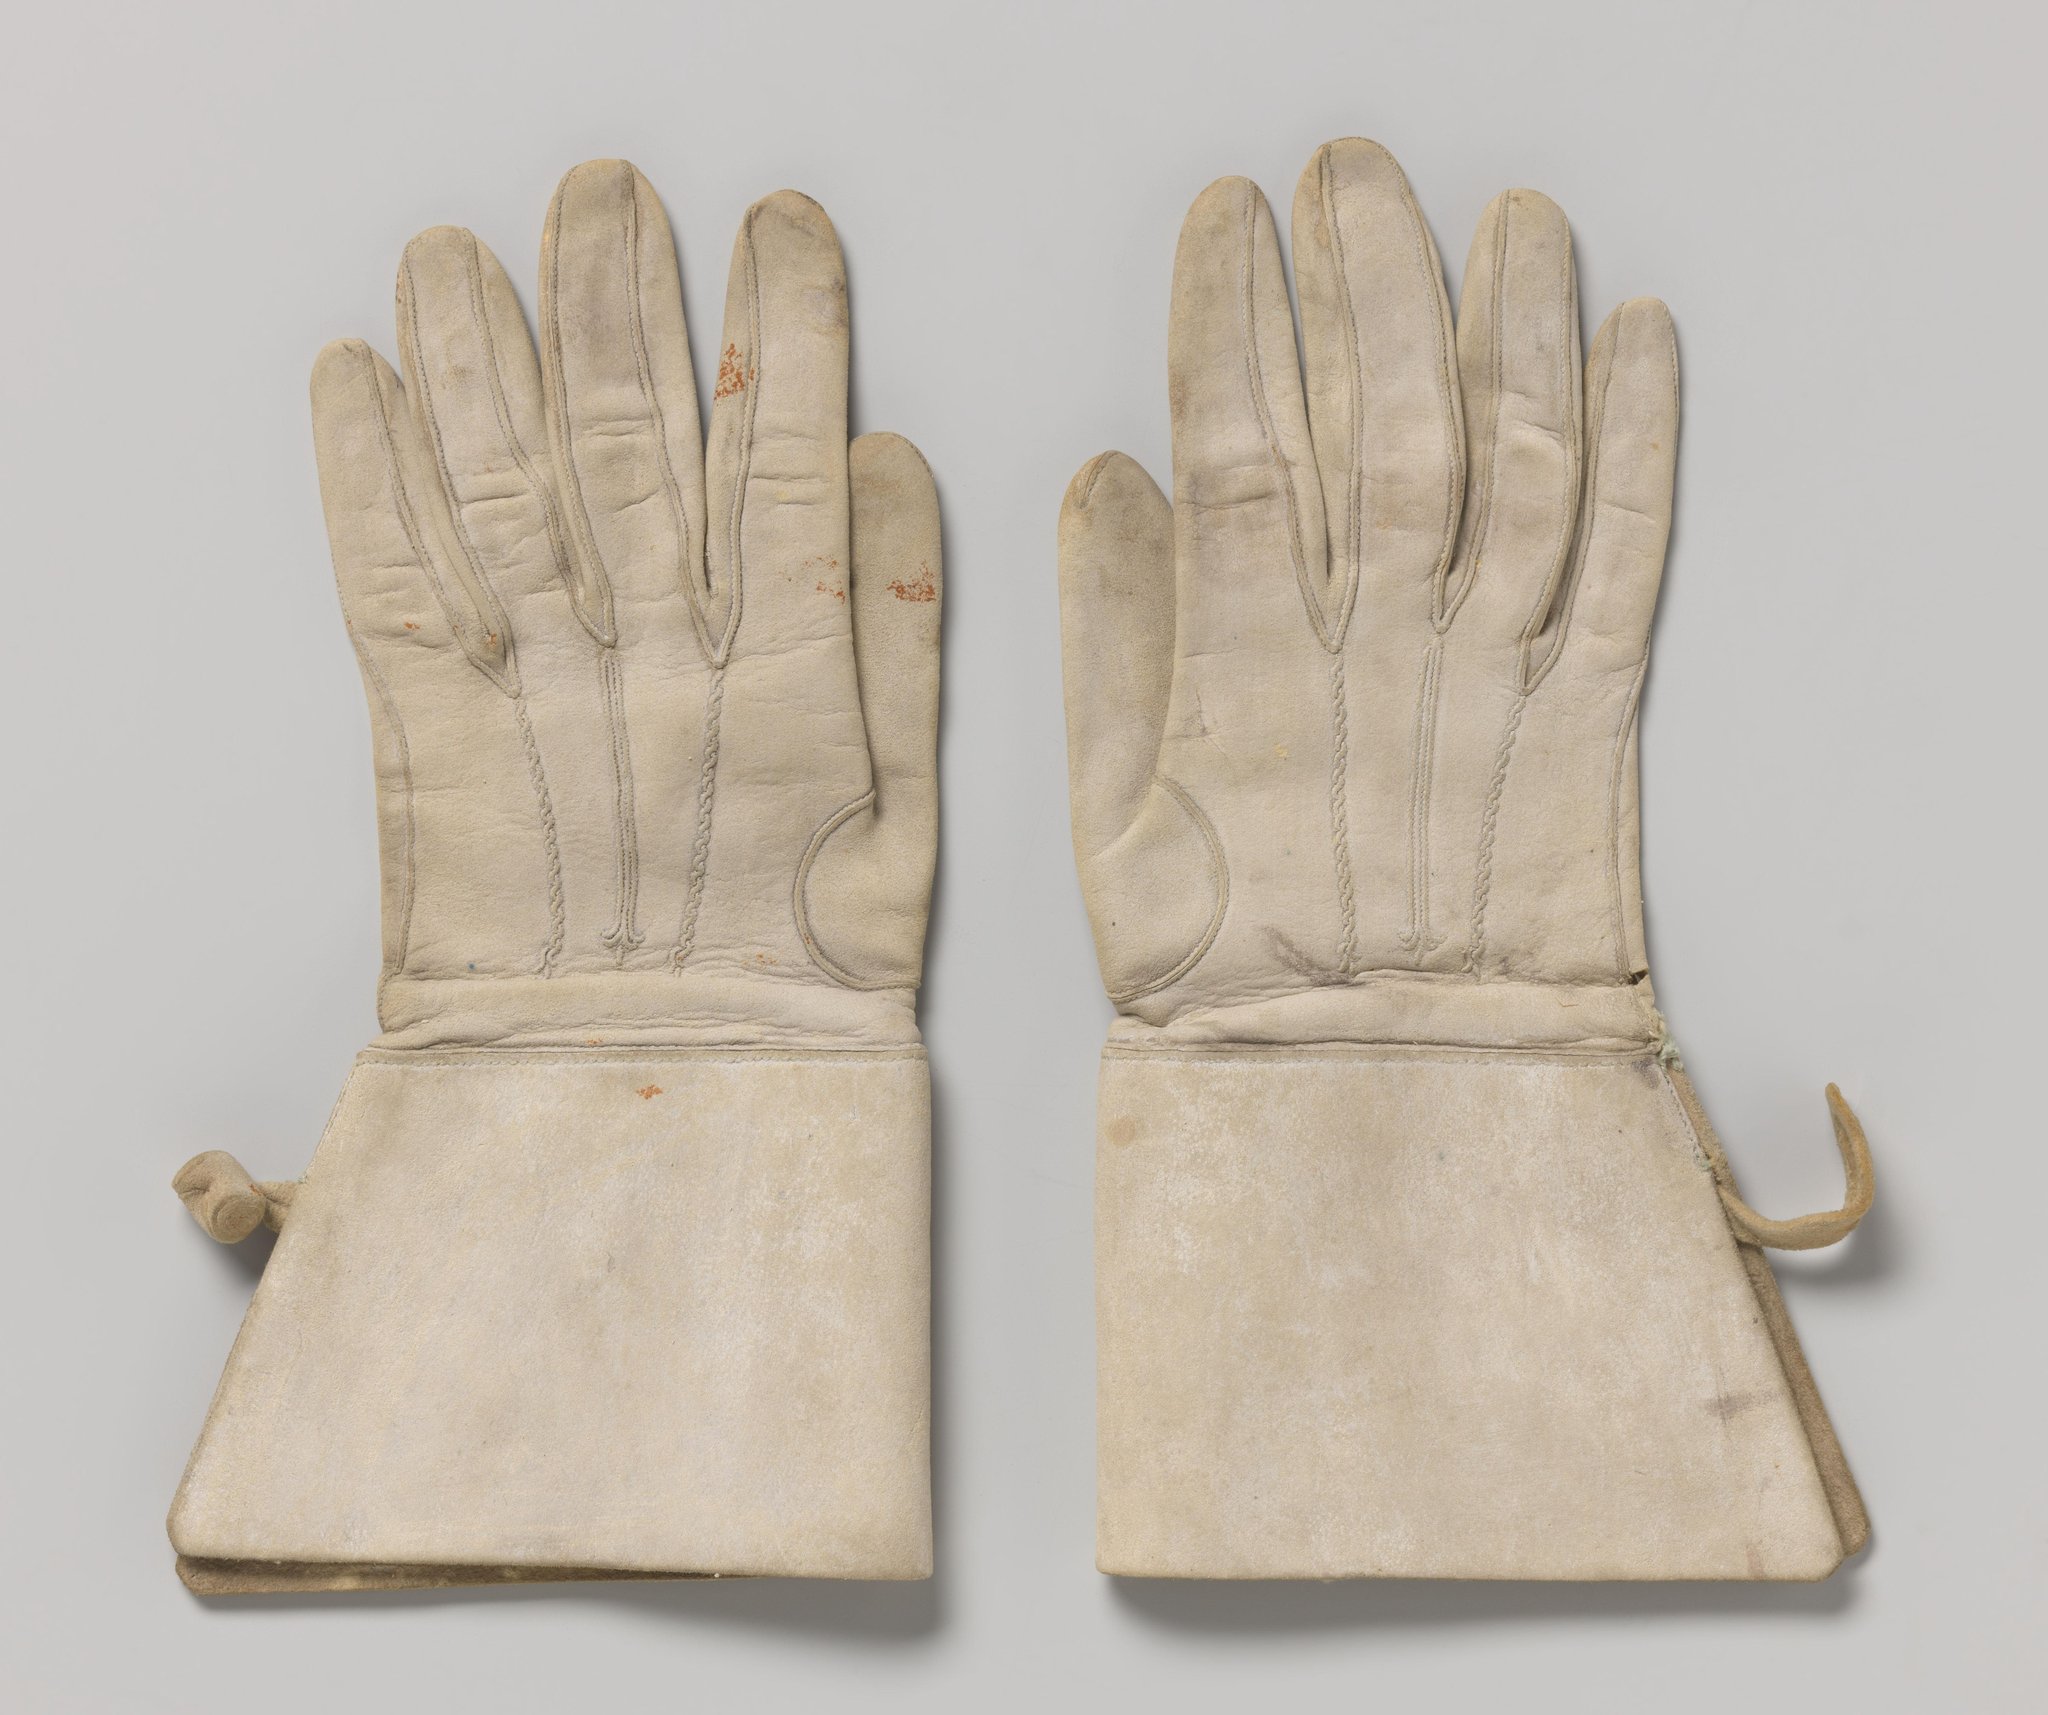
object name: glove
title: Paar handschoenen behorend tot de uitrusting van een sappeur van de 1e Afdeling Noord-Hollandse Schutterij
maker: Anonymous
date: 1800-1830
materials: leather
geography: netherlands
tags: noord-hollandse schutterij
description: Een paar handschoenen van wit leer. Afkomstig van de uitrusting van een sappeur van de 1e Afdeling Noord-Hollandse Schutterij.